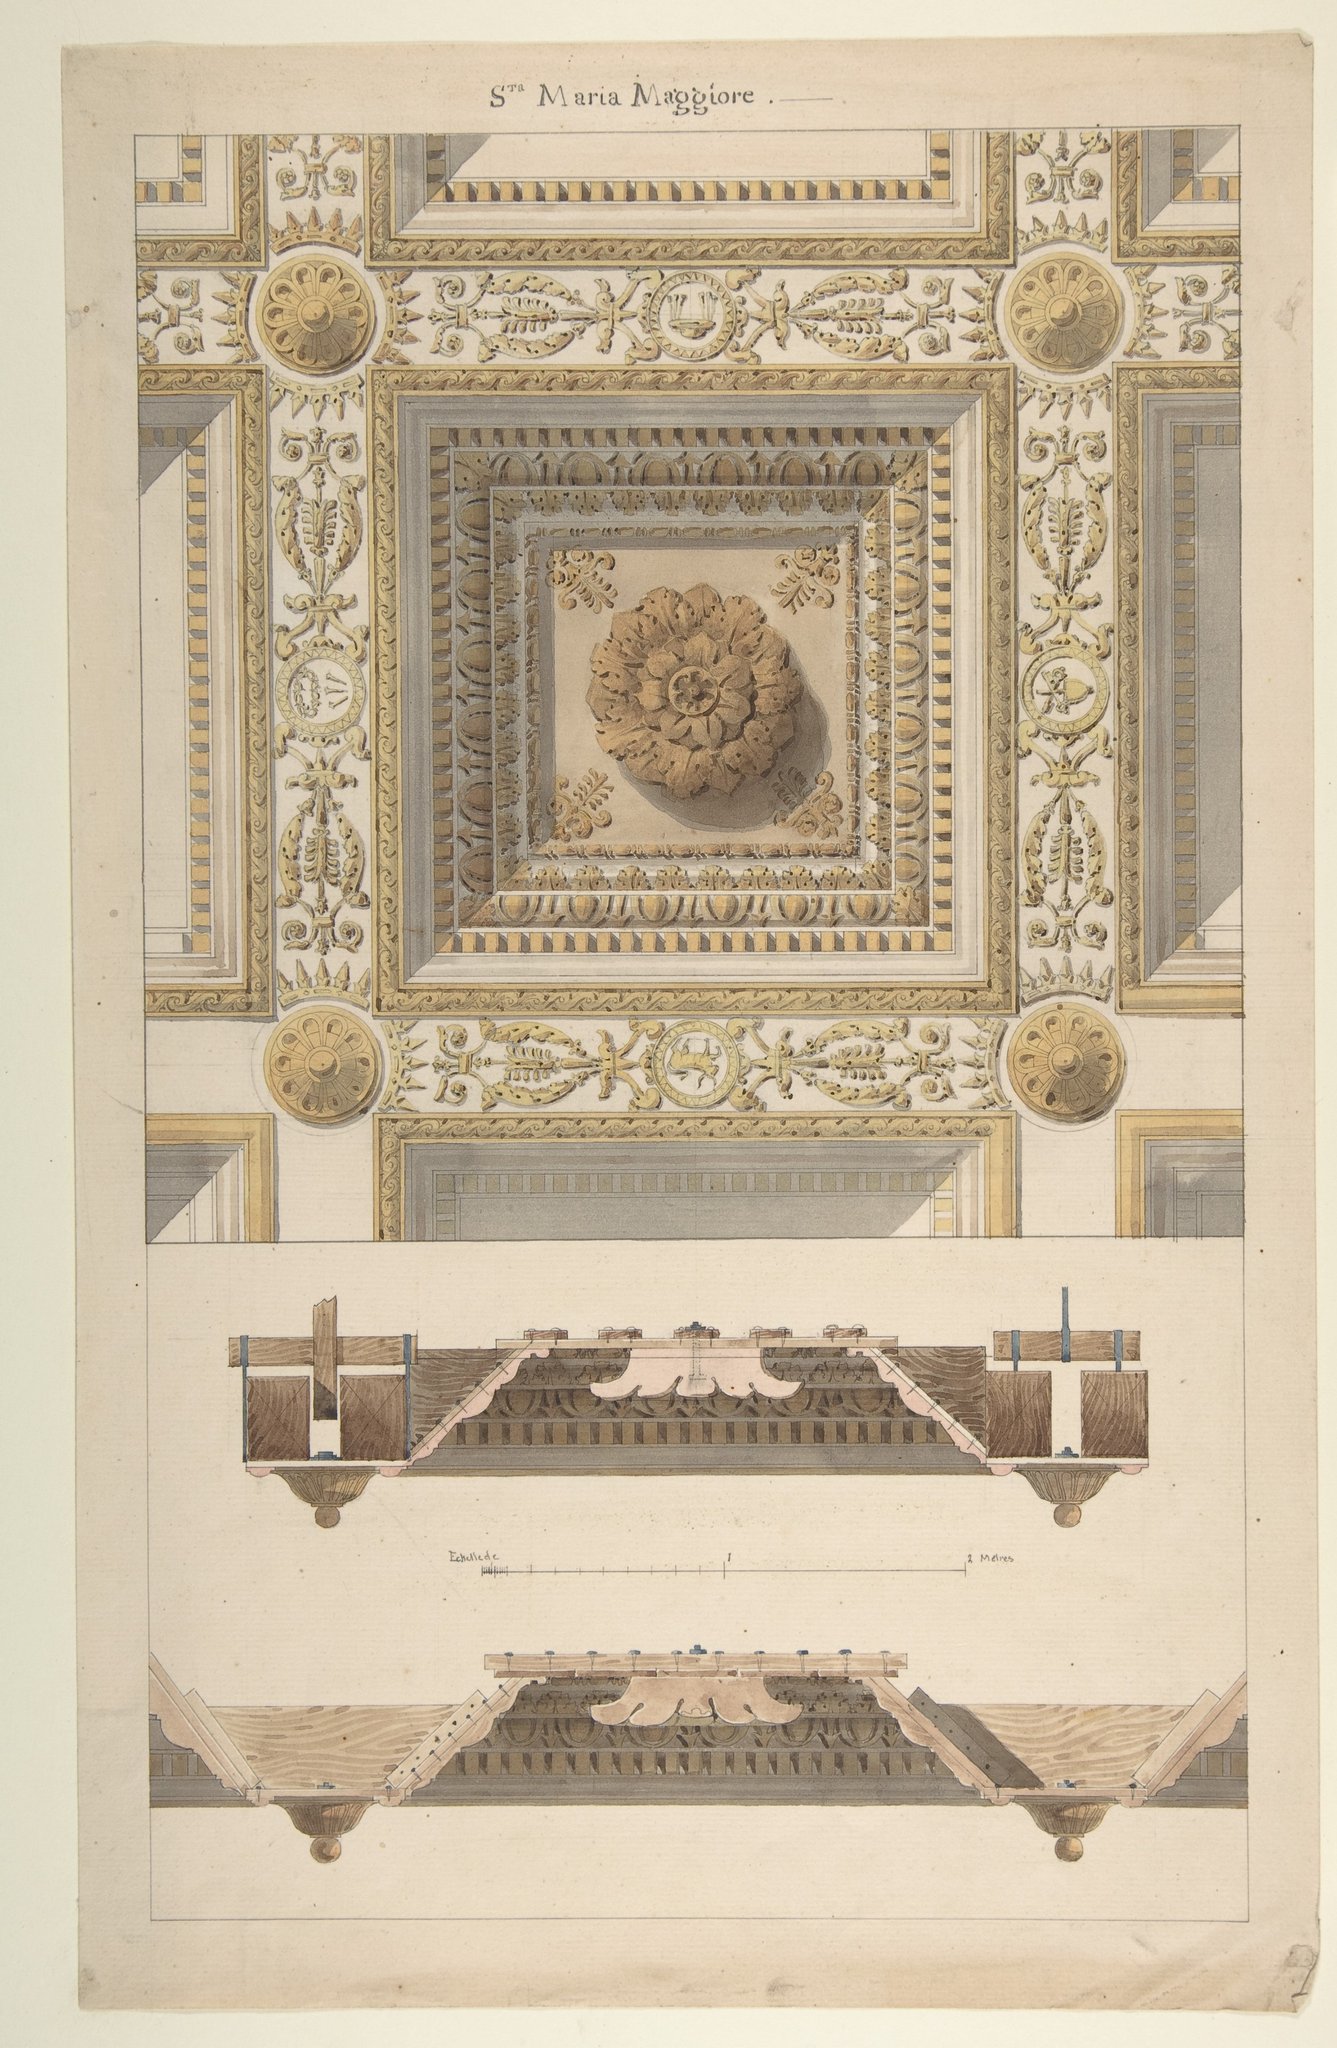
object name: drawing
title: Details of the Coffered and Beamed Ceiling in Santa Maria Maggiore, Rome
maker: anonymous, french, 19th century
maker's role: artist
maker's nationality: french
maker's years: 1800-1900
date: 1801-1900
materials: ink, watercolor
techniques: brush, pen, wash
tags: ceilings